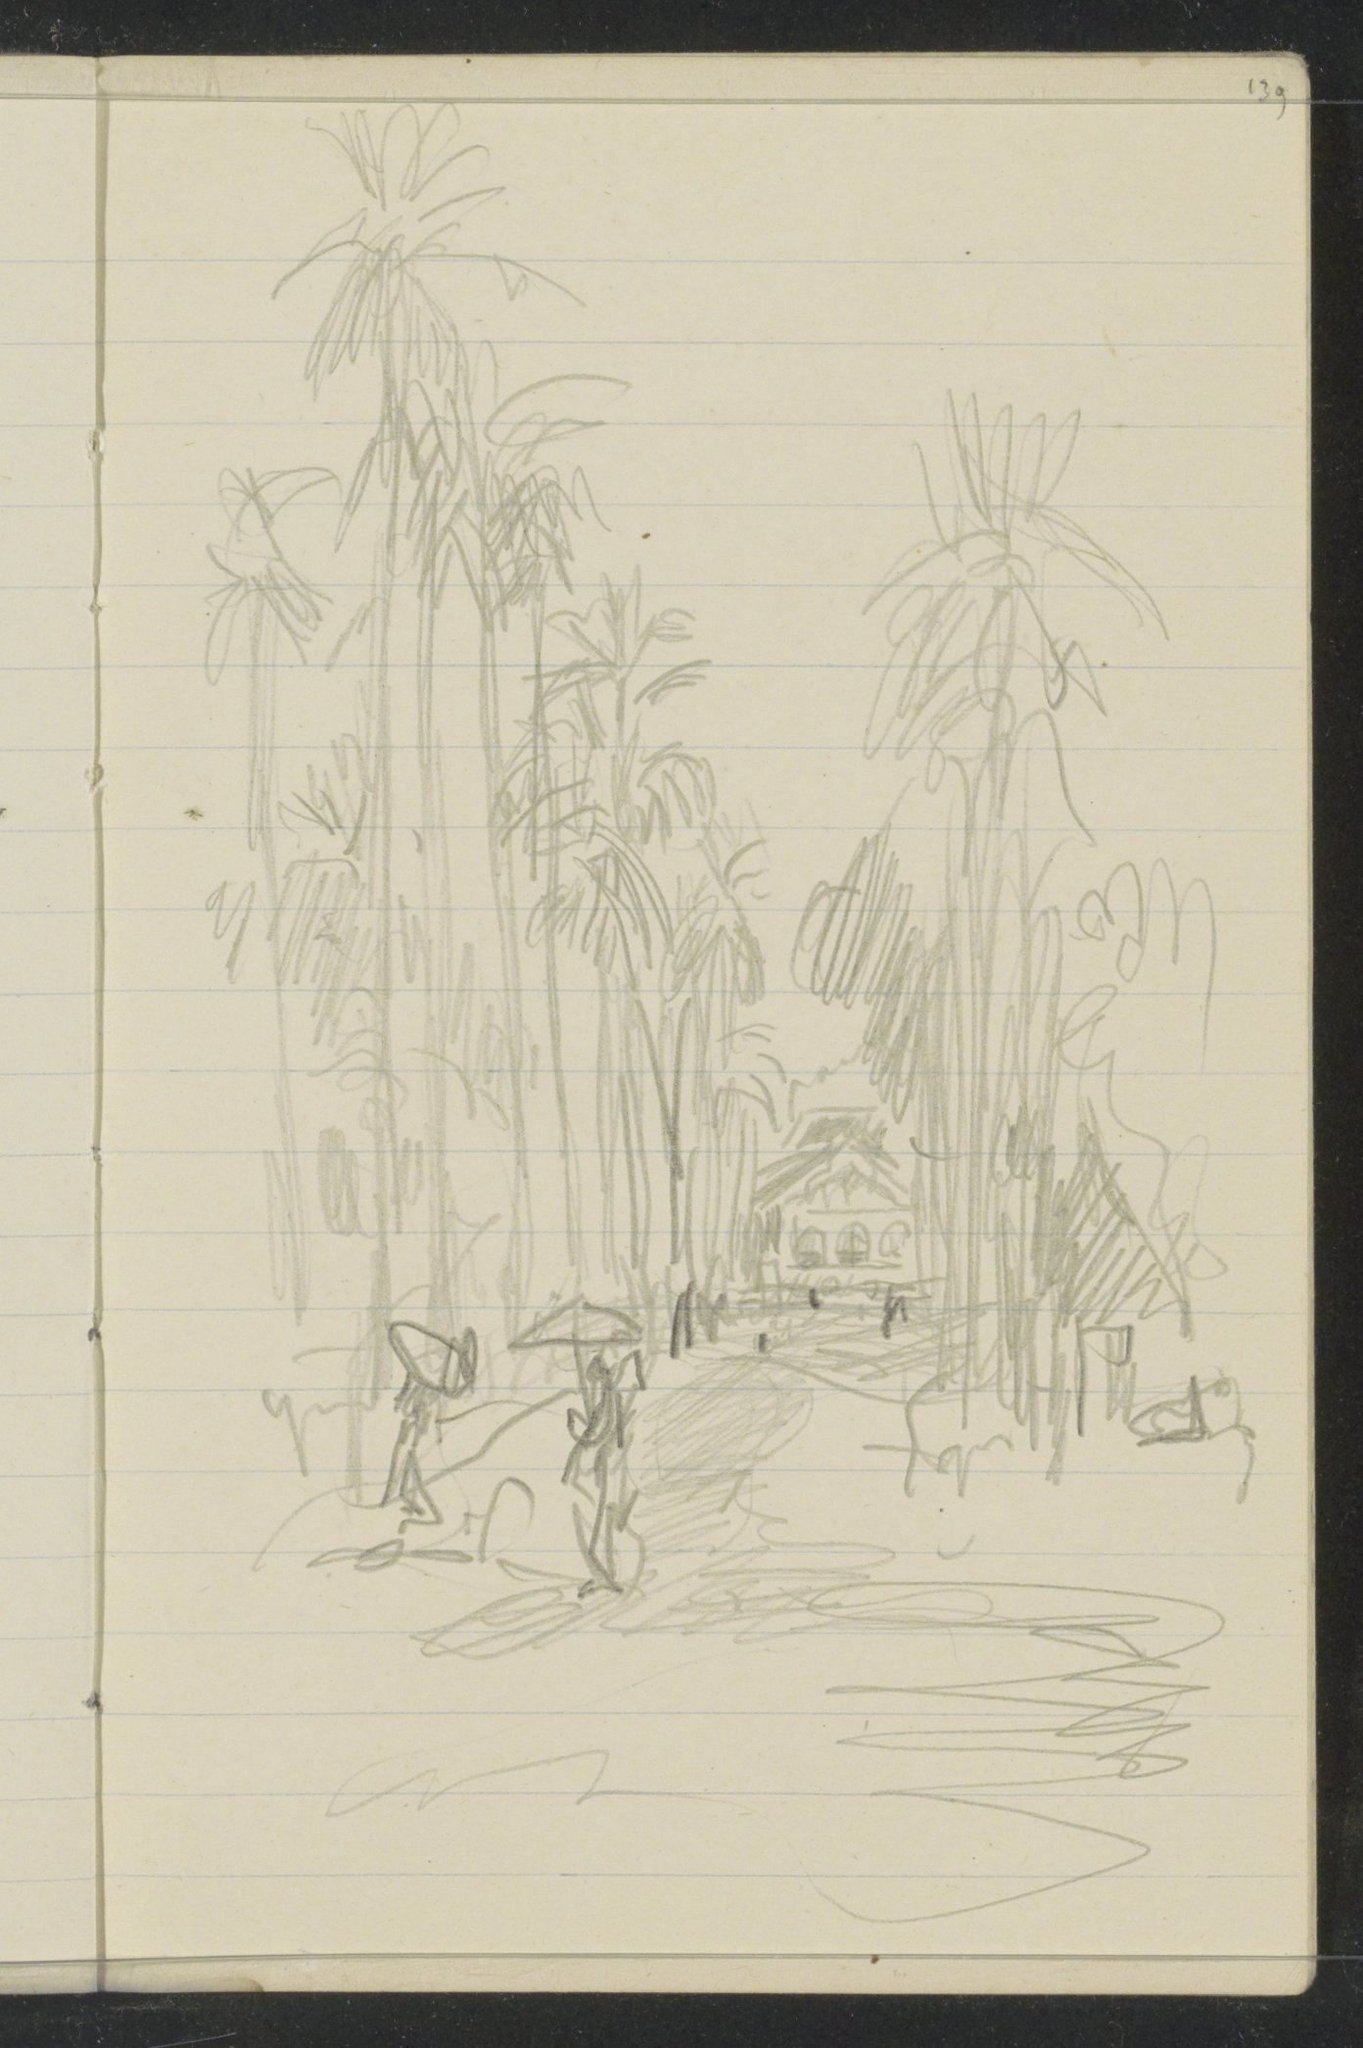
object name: sketchbook leaf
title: Figuren met parasols op een landweg geflankeerd door palmbomen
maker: marius bauer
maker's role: draughtsman, print maker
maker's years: 1867-1932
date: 1931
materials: pencil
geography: medan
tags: road, path, trees: palm-tree, landscapes (+ landscape with figures, staffage), parasol, sunshade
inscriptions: kleurnotitie, handgeschreven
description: Pagina 139 uit een schetsboek met 74 bladen.